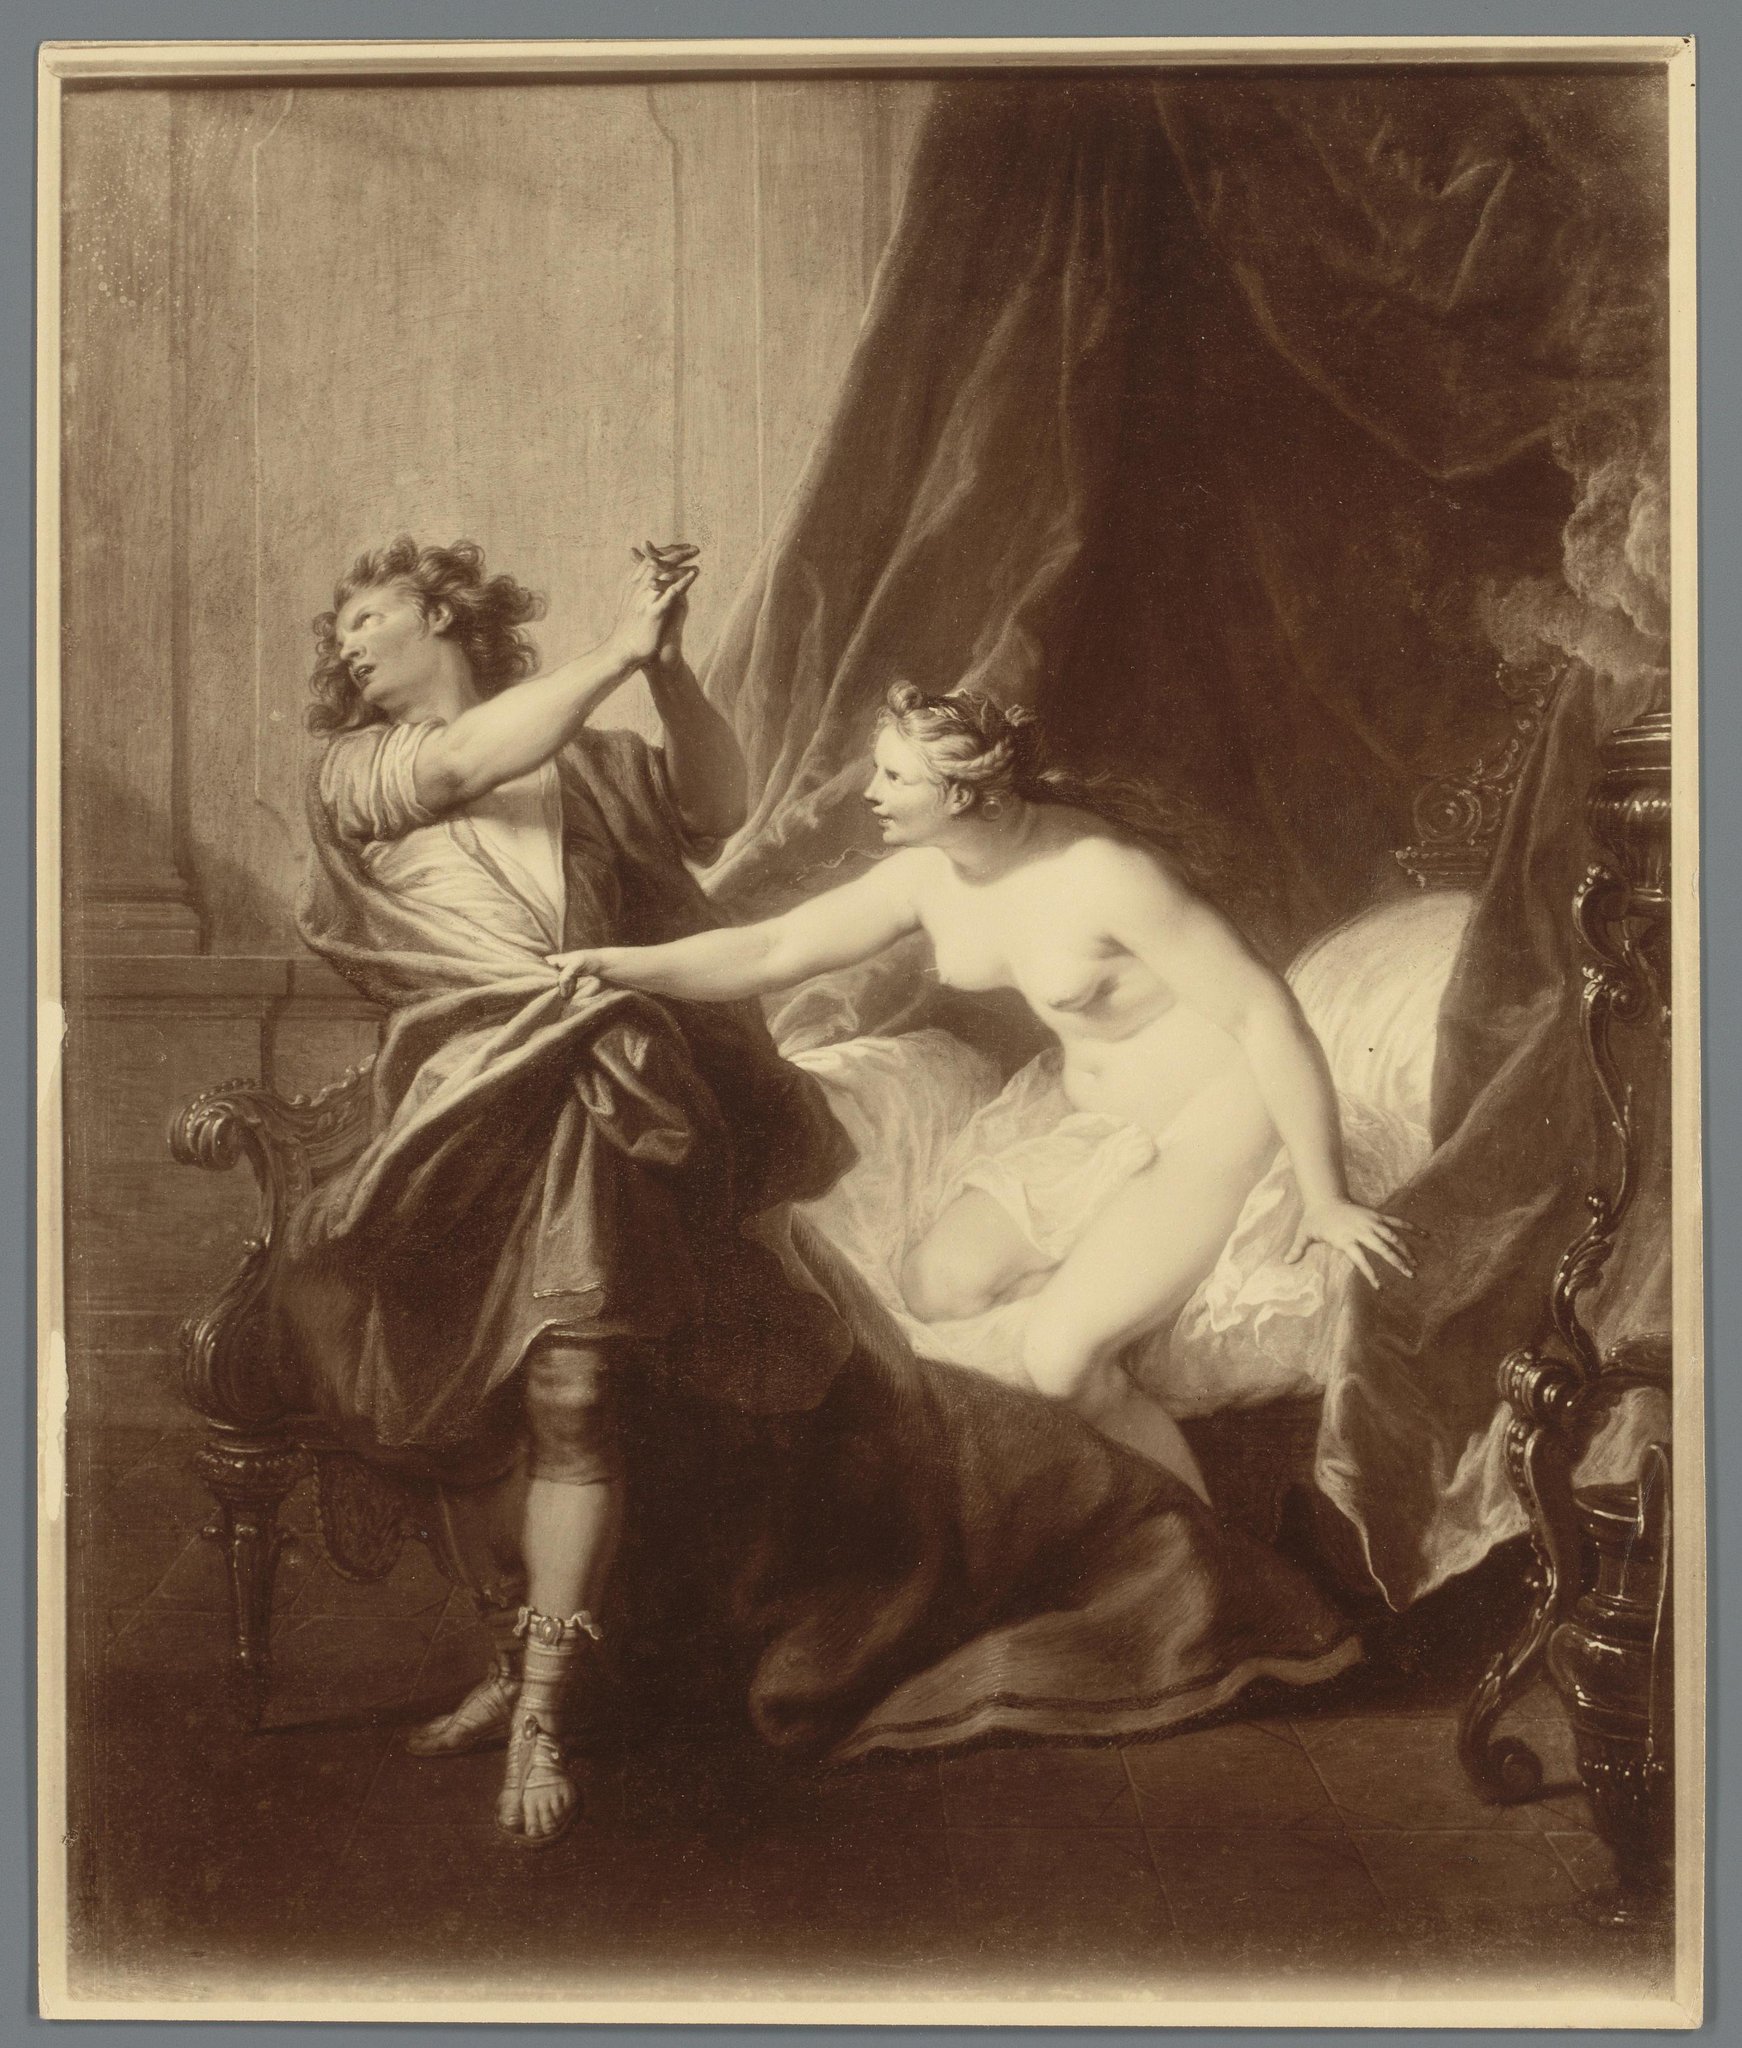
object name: photograph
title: Fotoreproductie van het schilderij Jozef en de vrouw van Potifar door Nicolas Bertin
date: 1860-1900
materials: paper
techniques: albumen print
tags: potiphar's wife catches joseph by his robe, usually while lying in bed; joseph escapes leaving his cloak behind in her hands (possibly with a naked child lying in a crib)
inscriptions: inscription: ‘499/ Nicolas Bertin/ Coll. Rijksmuseum’